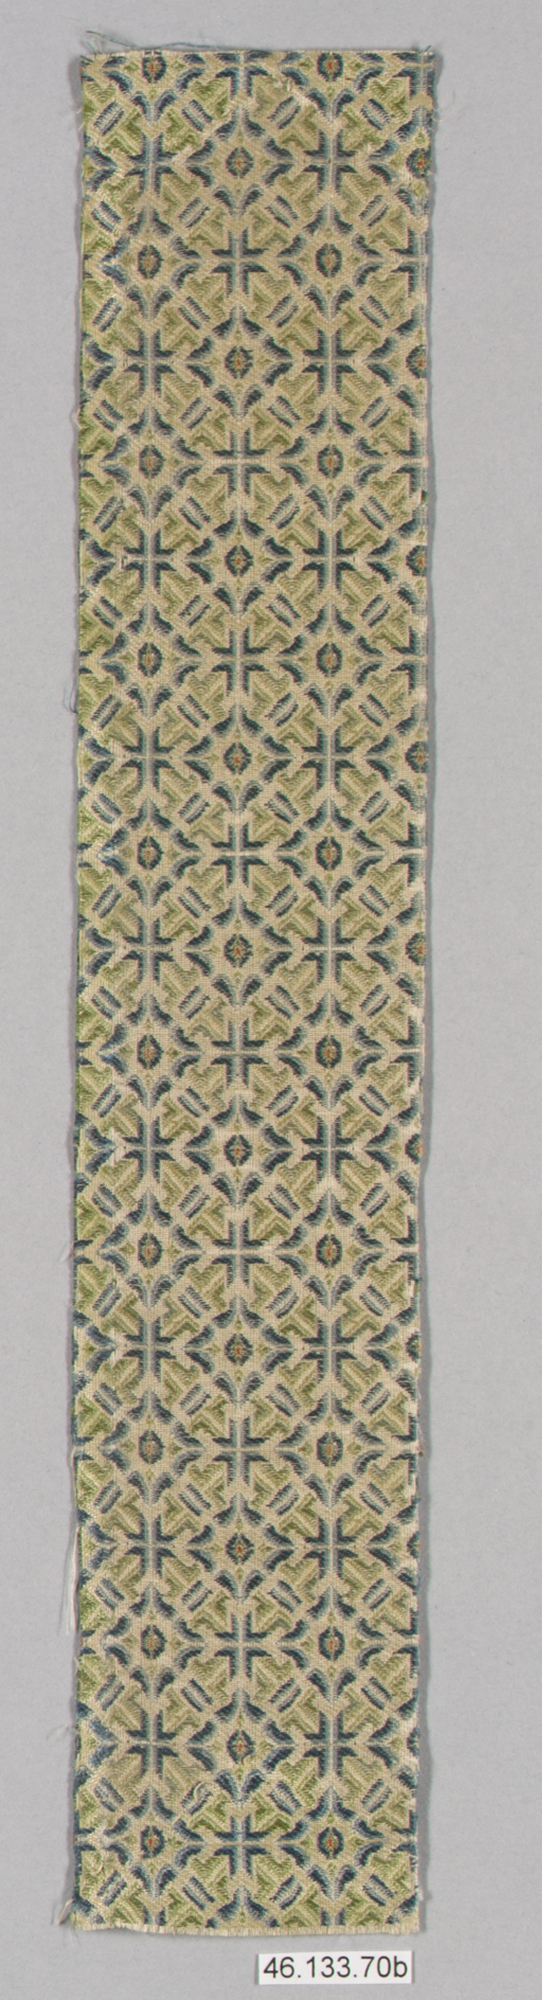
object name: piece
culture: chinese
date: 1401-1600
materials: silk